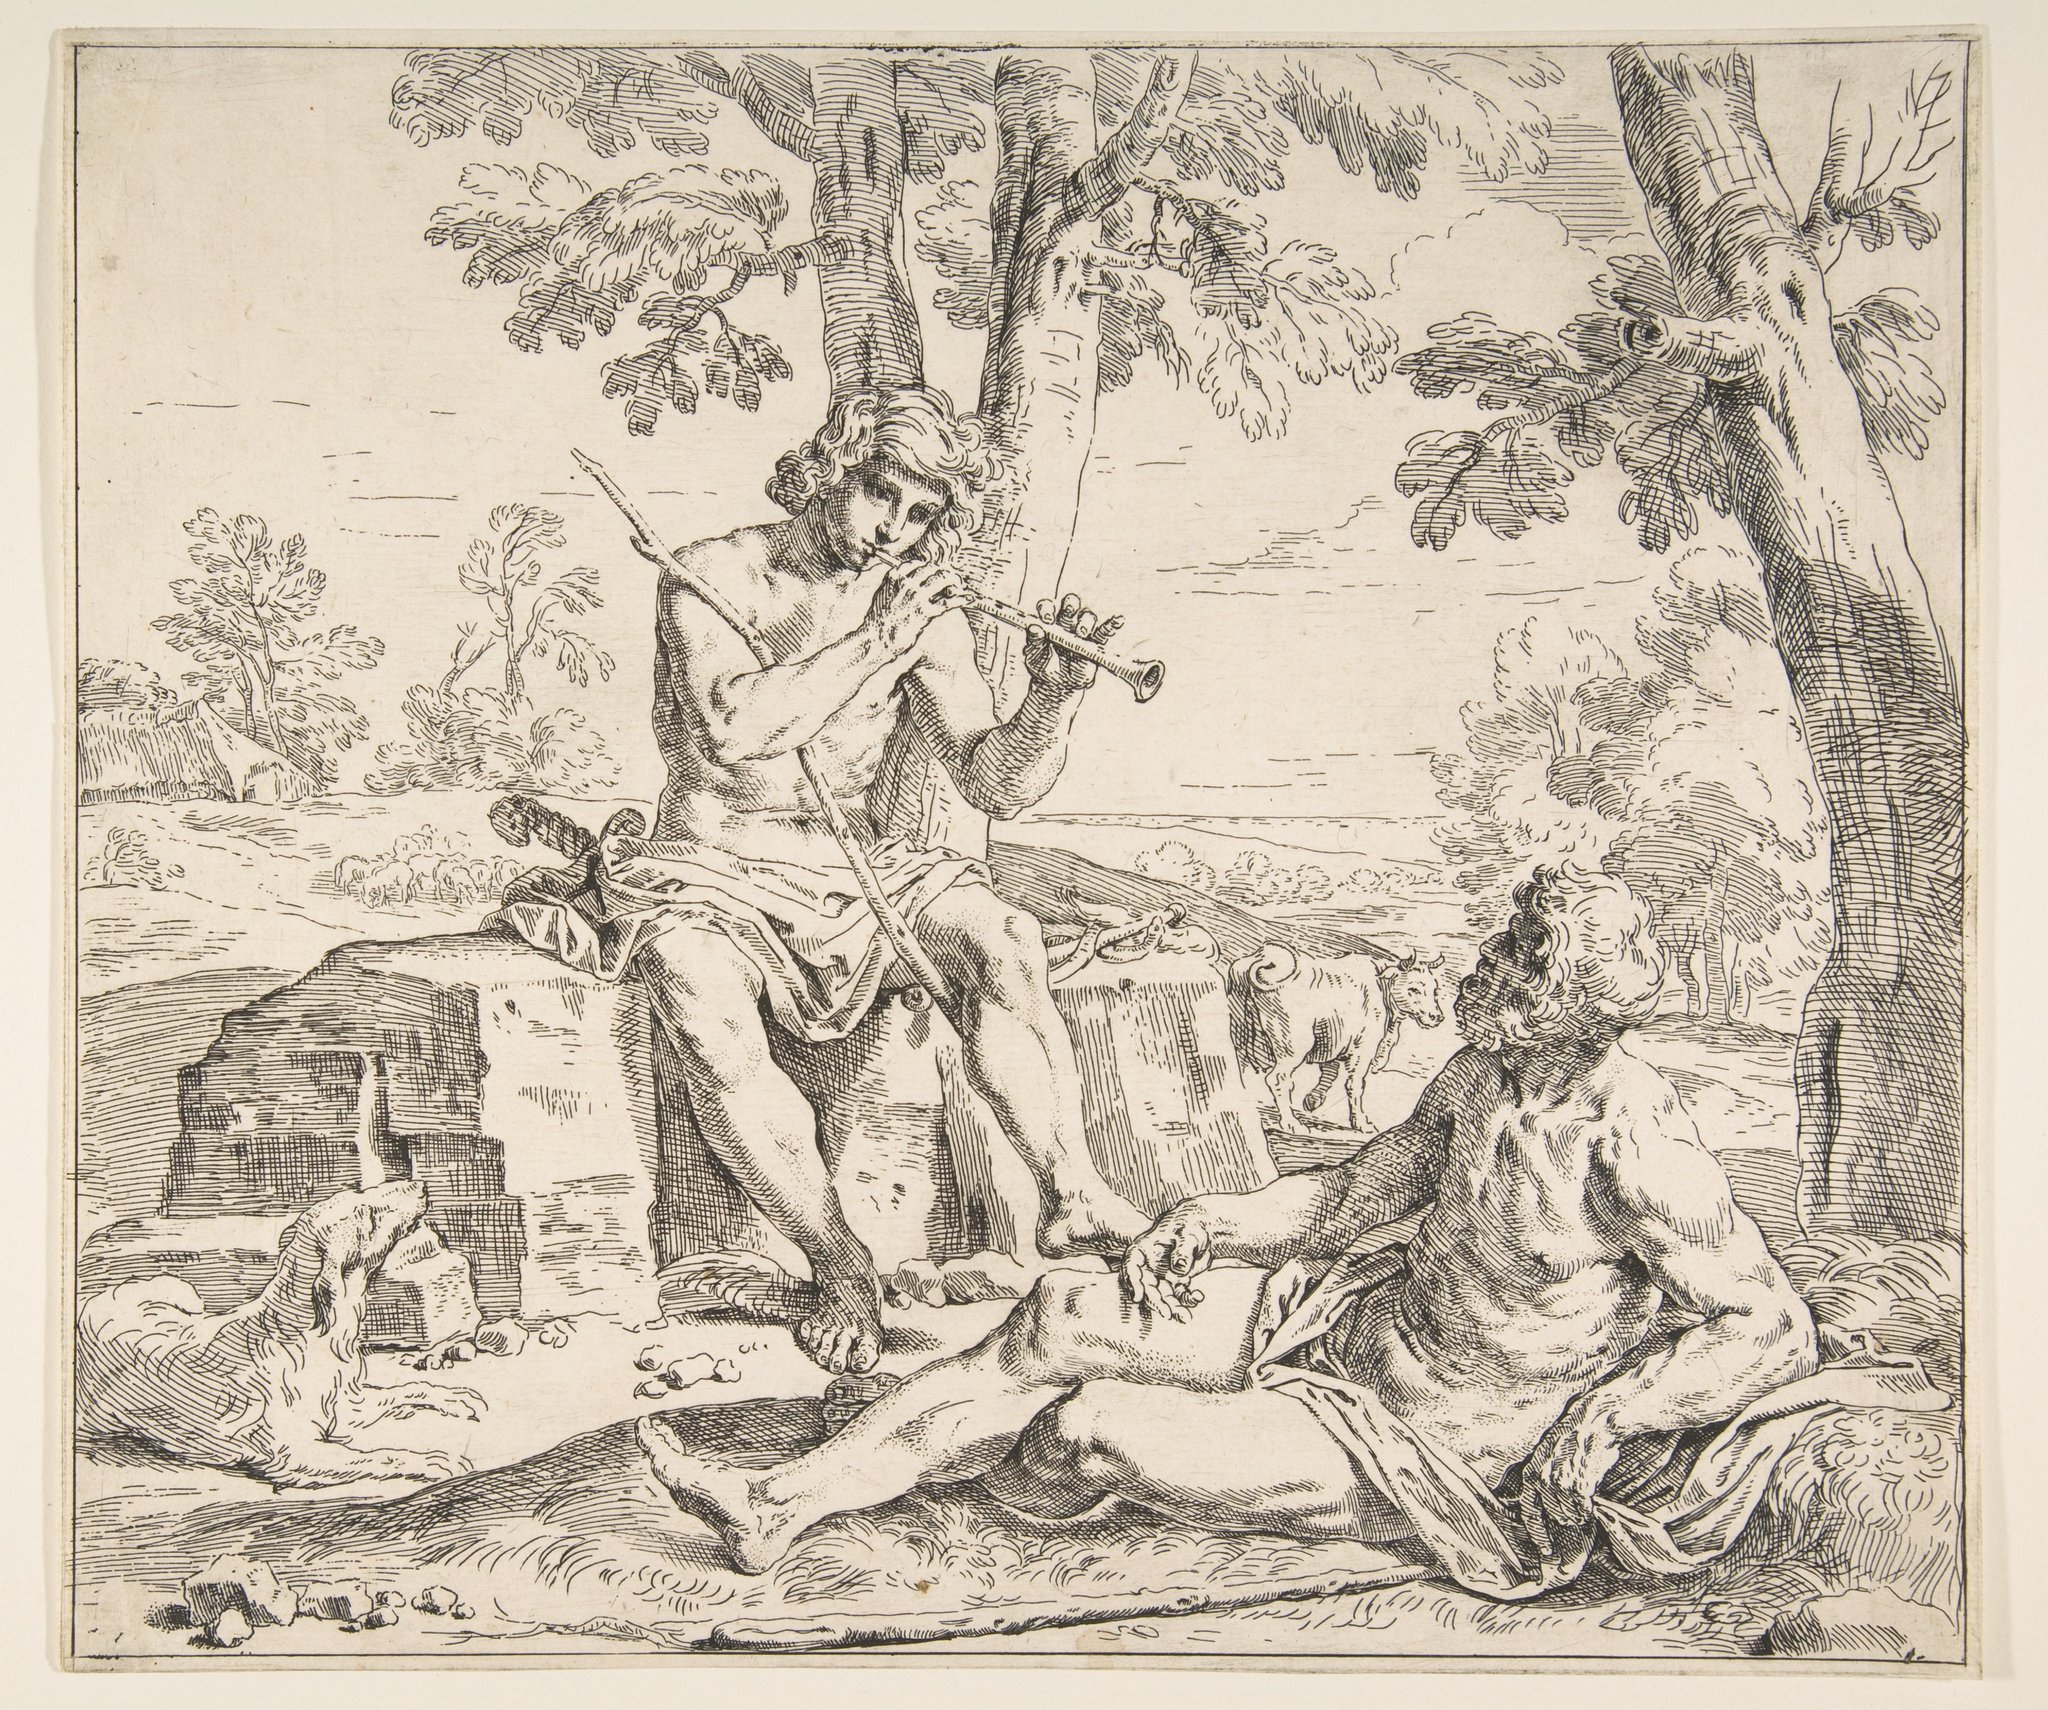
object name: print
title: Mercury and Argus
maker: simone cantarini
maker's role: artist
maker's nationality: italian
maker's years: 1612-1648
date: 1630-1648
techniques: etching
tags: musical instruments,men,mercury